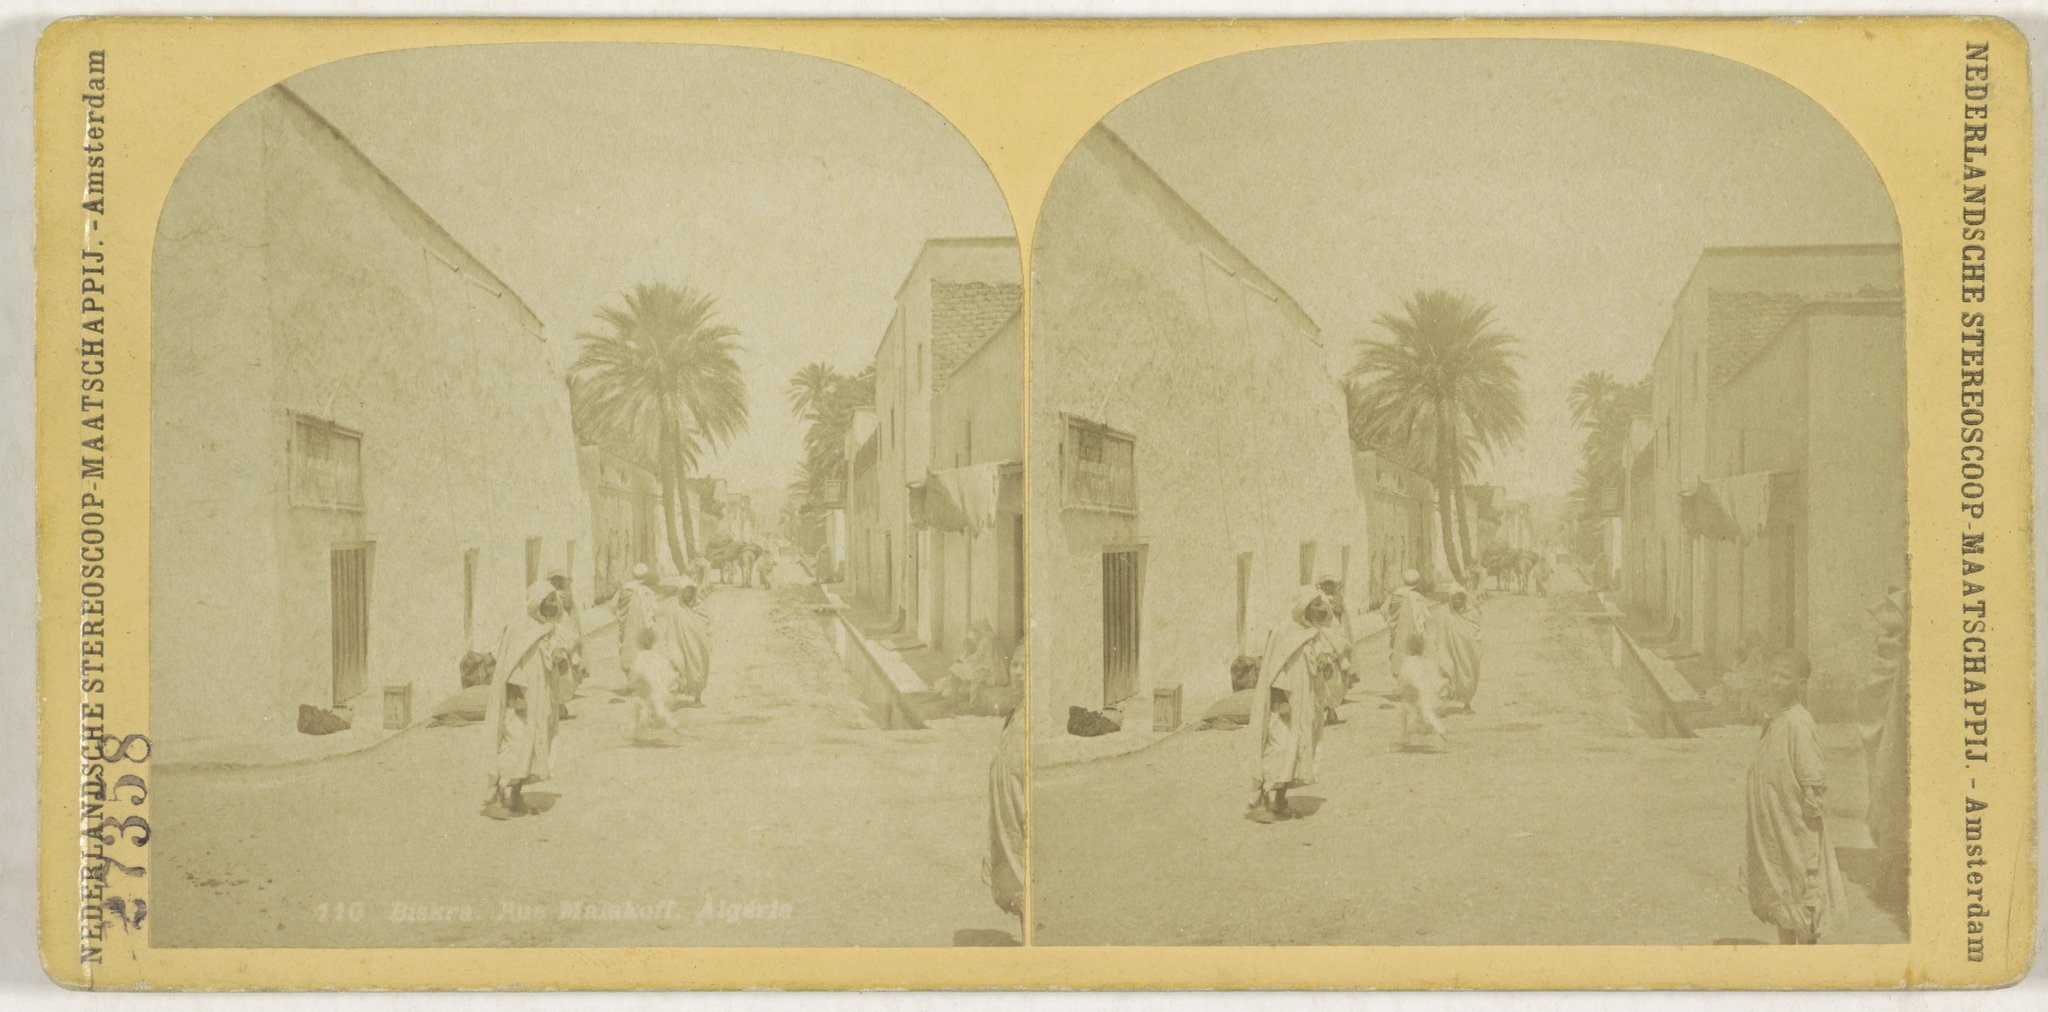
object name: stereograph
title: Straatbeeld in de Rue Malakoff, Biskra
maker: j.g. beers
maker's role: fotograaf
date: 1868-1890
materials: cardboard, paper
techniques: albumen print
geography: amsterdam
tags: street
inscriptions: number: ‘27358’, number: ‘110’